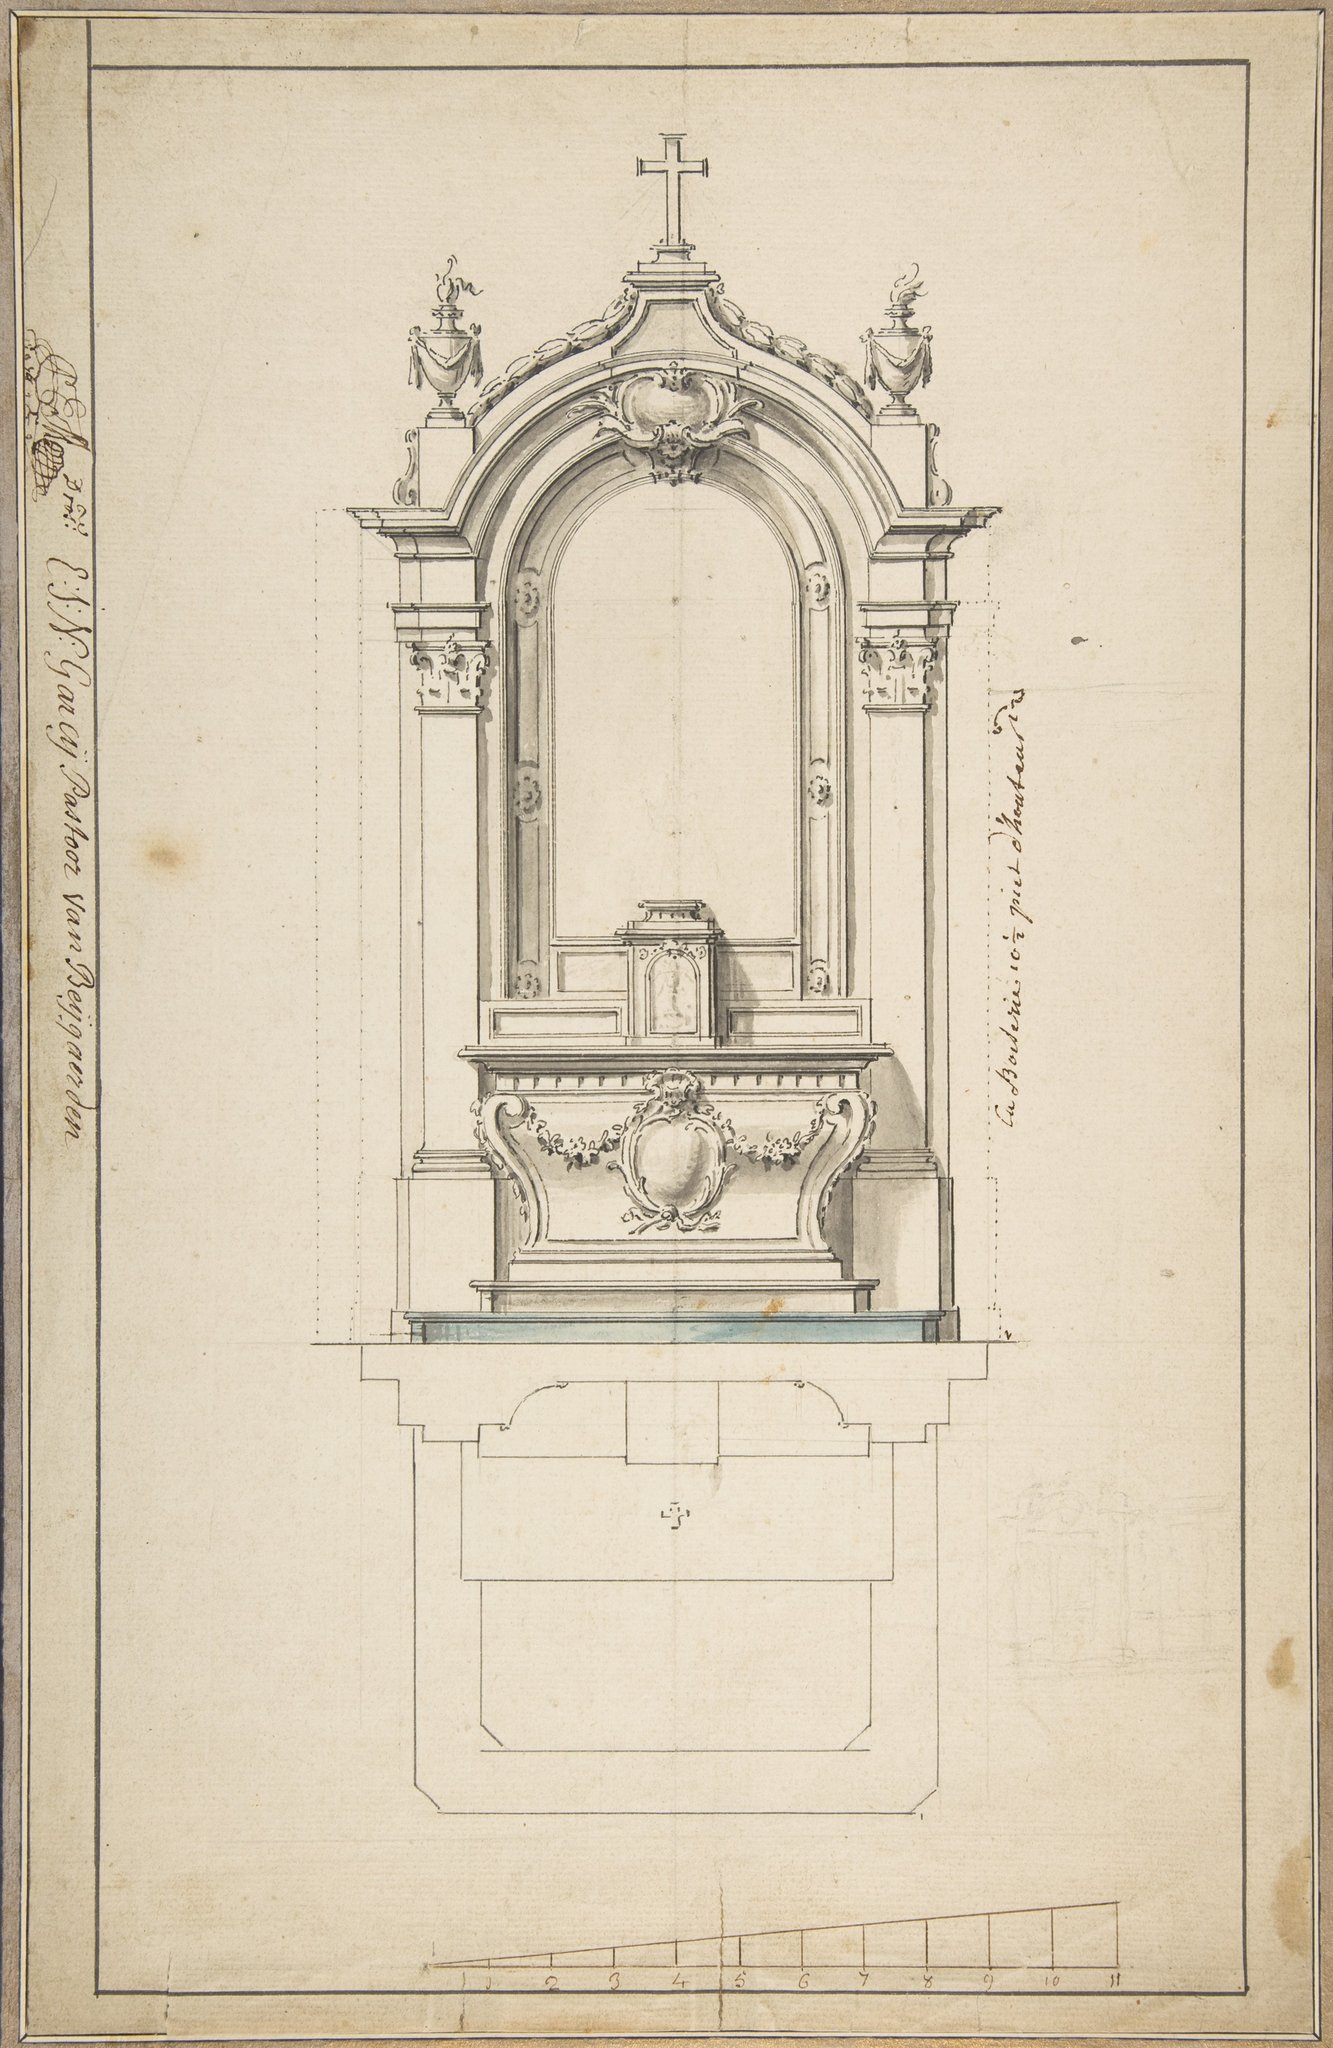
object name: drawing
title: Design for an Altar, with Elevation and Ground Plan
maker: anonymous, french, 18th century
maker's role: artist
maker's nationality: french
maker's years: 1700-1800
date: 1701-1800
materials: ink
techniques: brush, pen, wash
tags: architecture,altars